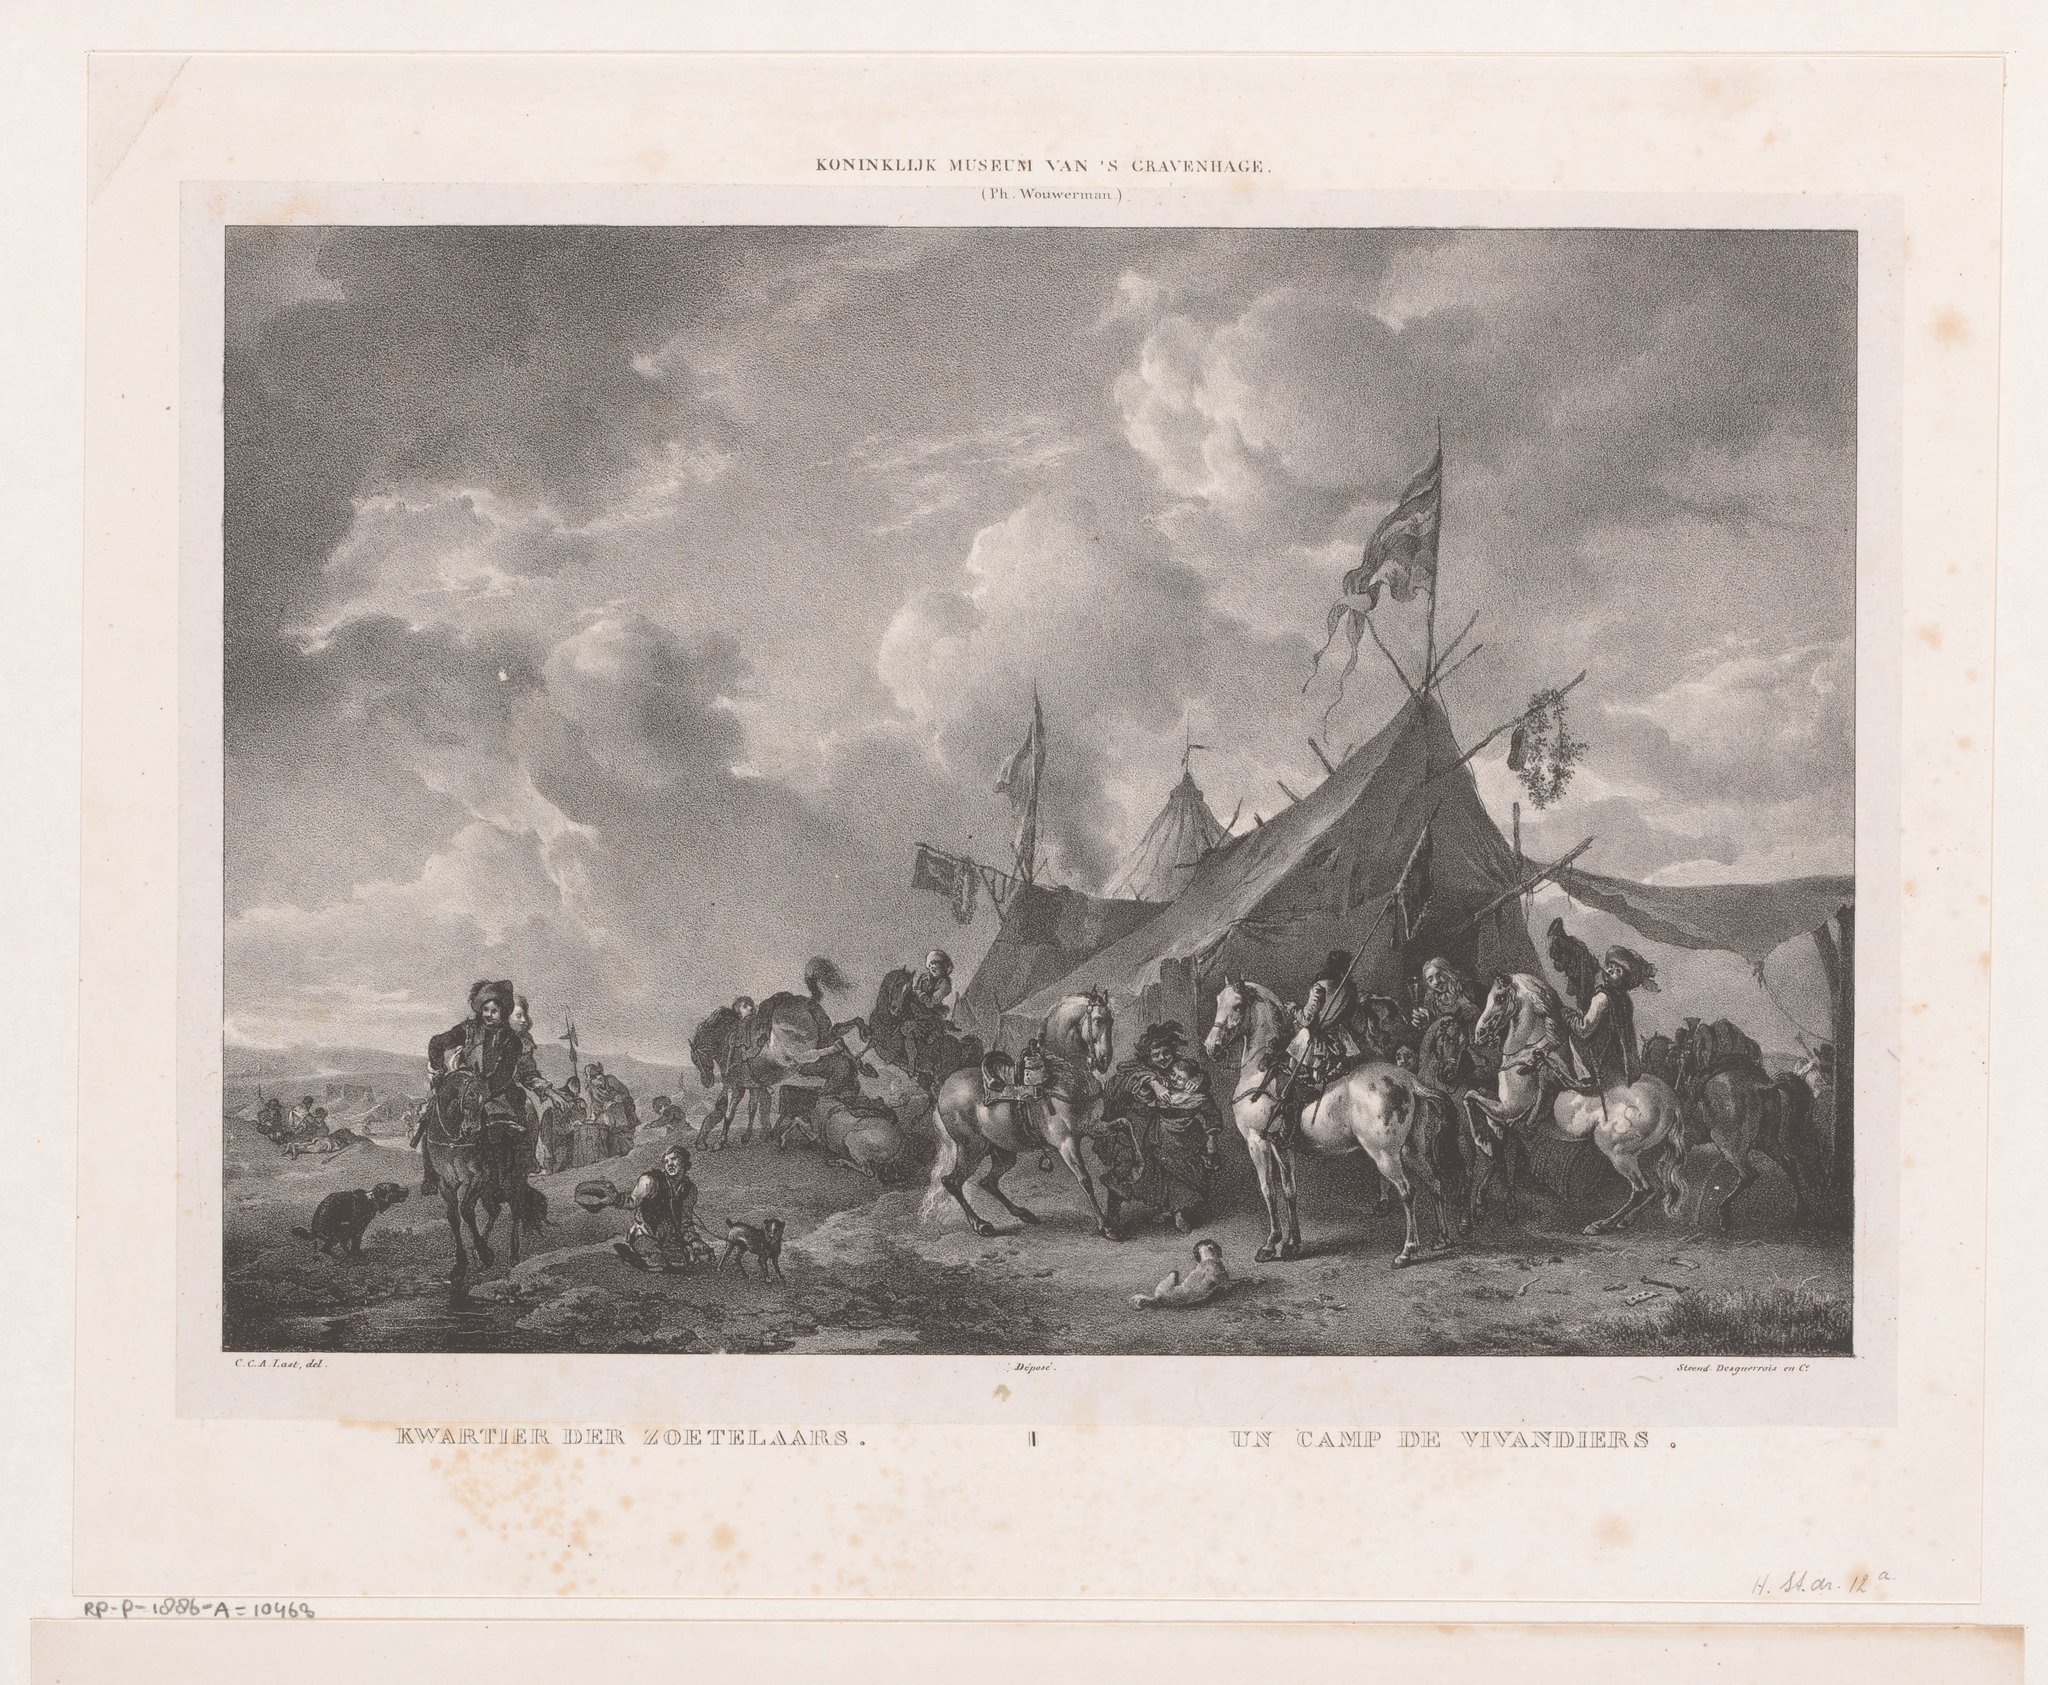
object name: print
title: Portretbuste van Johannes Lutma de Oude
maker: johannes lutma (1624-1689)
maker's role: print maker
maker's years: 1624-1689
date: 1634-1689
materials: paper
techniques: engraving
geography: amsterdam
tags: print maker, draughtsman, silversmith, johannes lutma (1584-1669), piece of sculpture, reproduction of a piece of sculpture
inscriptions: collector's mark: Lugt 2228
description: Portretbuste van de kunstenaar Johannes Lutma de Oude, op 85-jarige leeftijd.